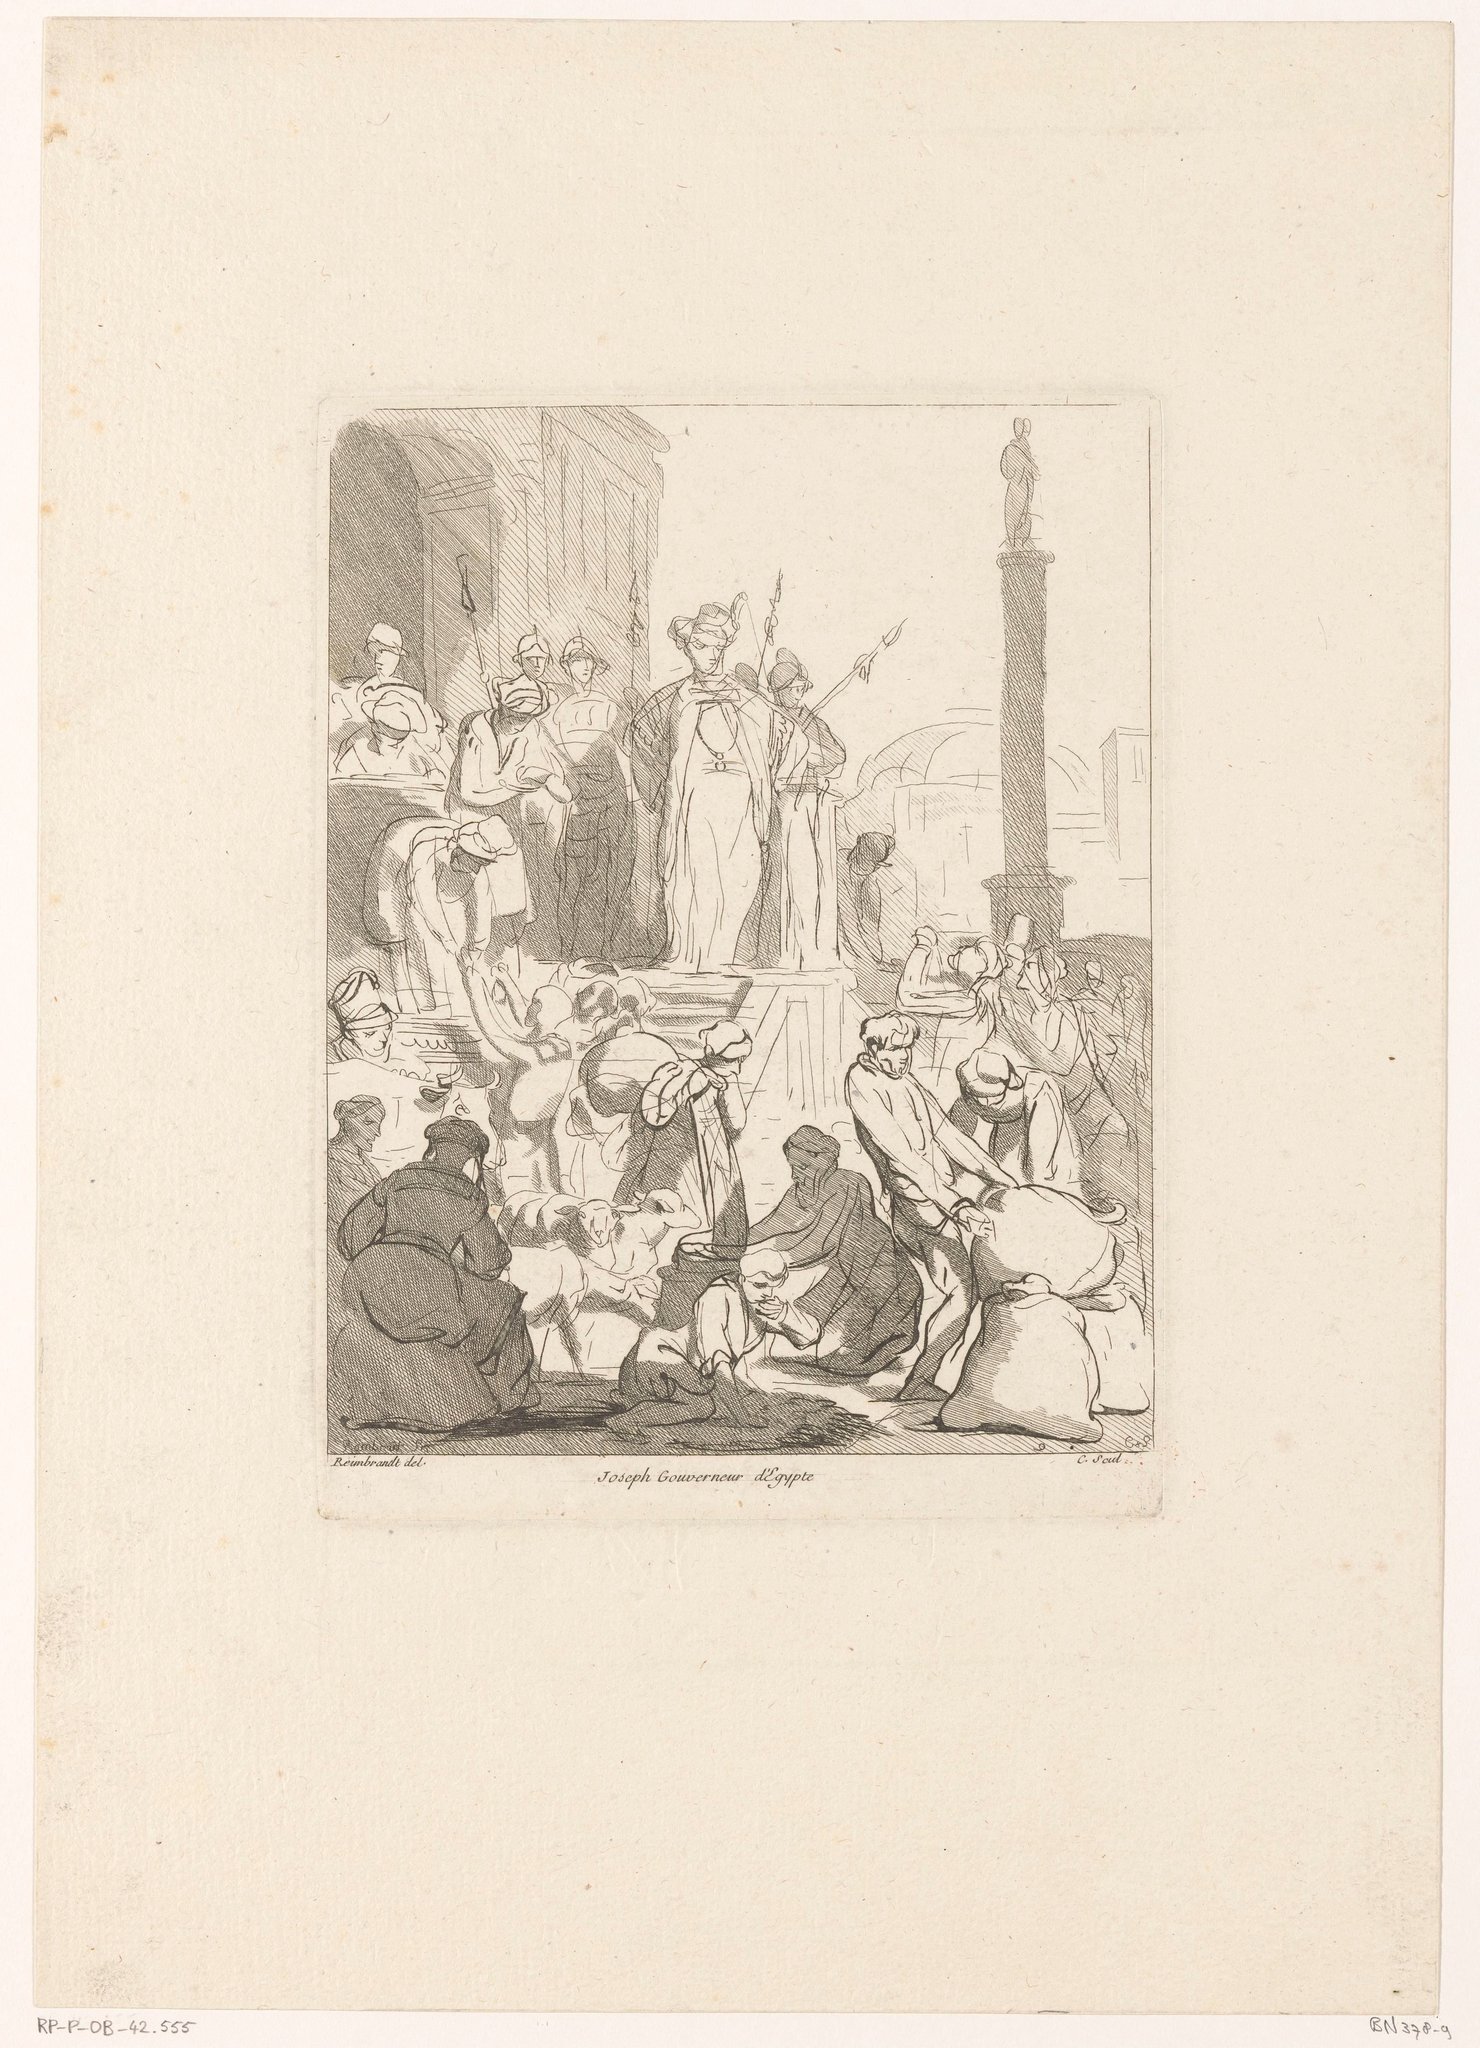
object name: print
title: Histoire de Joseph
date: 1702-1753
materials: paper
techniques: etching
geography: france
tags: joseph as overseer of pharaoh, genesis: the story of joseph, joseph prepares for the famine and stores up corn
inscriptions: collector's mark: Lugt 240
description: Maakt deel uit van een serie getiteld: "Histoire de Joseph", bestaande uit tien platen naar tekeningen, voorheen toegeschreven aan Rembrandt, maar tegenwoordig gecatalogiseerd als tekeningen in de manier van Rembrandt, waarbij de naam Gerbrandt van den Eeckhout wordt gesuggereerd. De serie wordt genoemd in een veilingcatalogus van Coypel in 1753. In 1757 werd de serie uitgegeven door Jean Néaulme in Amsterdam.